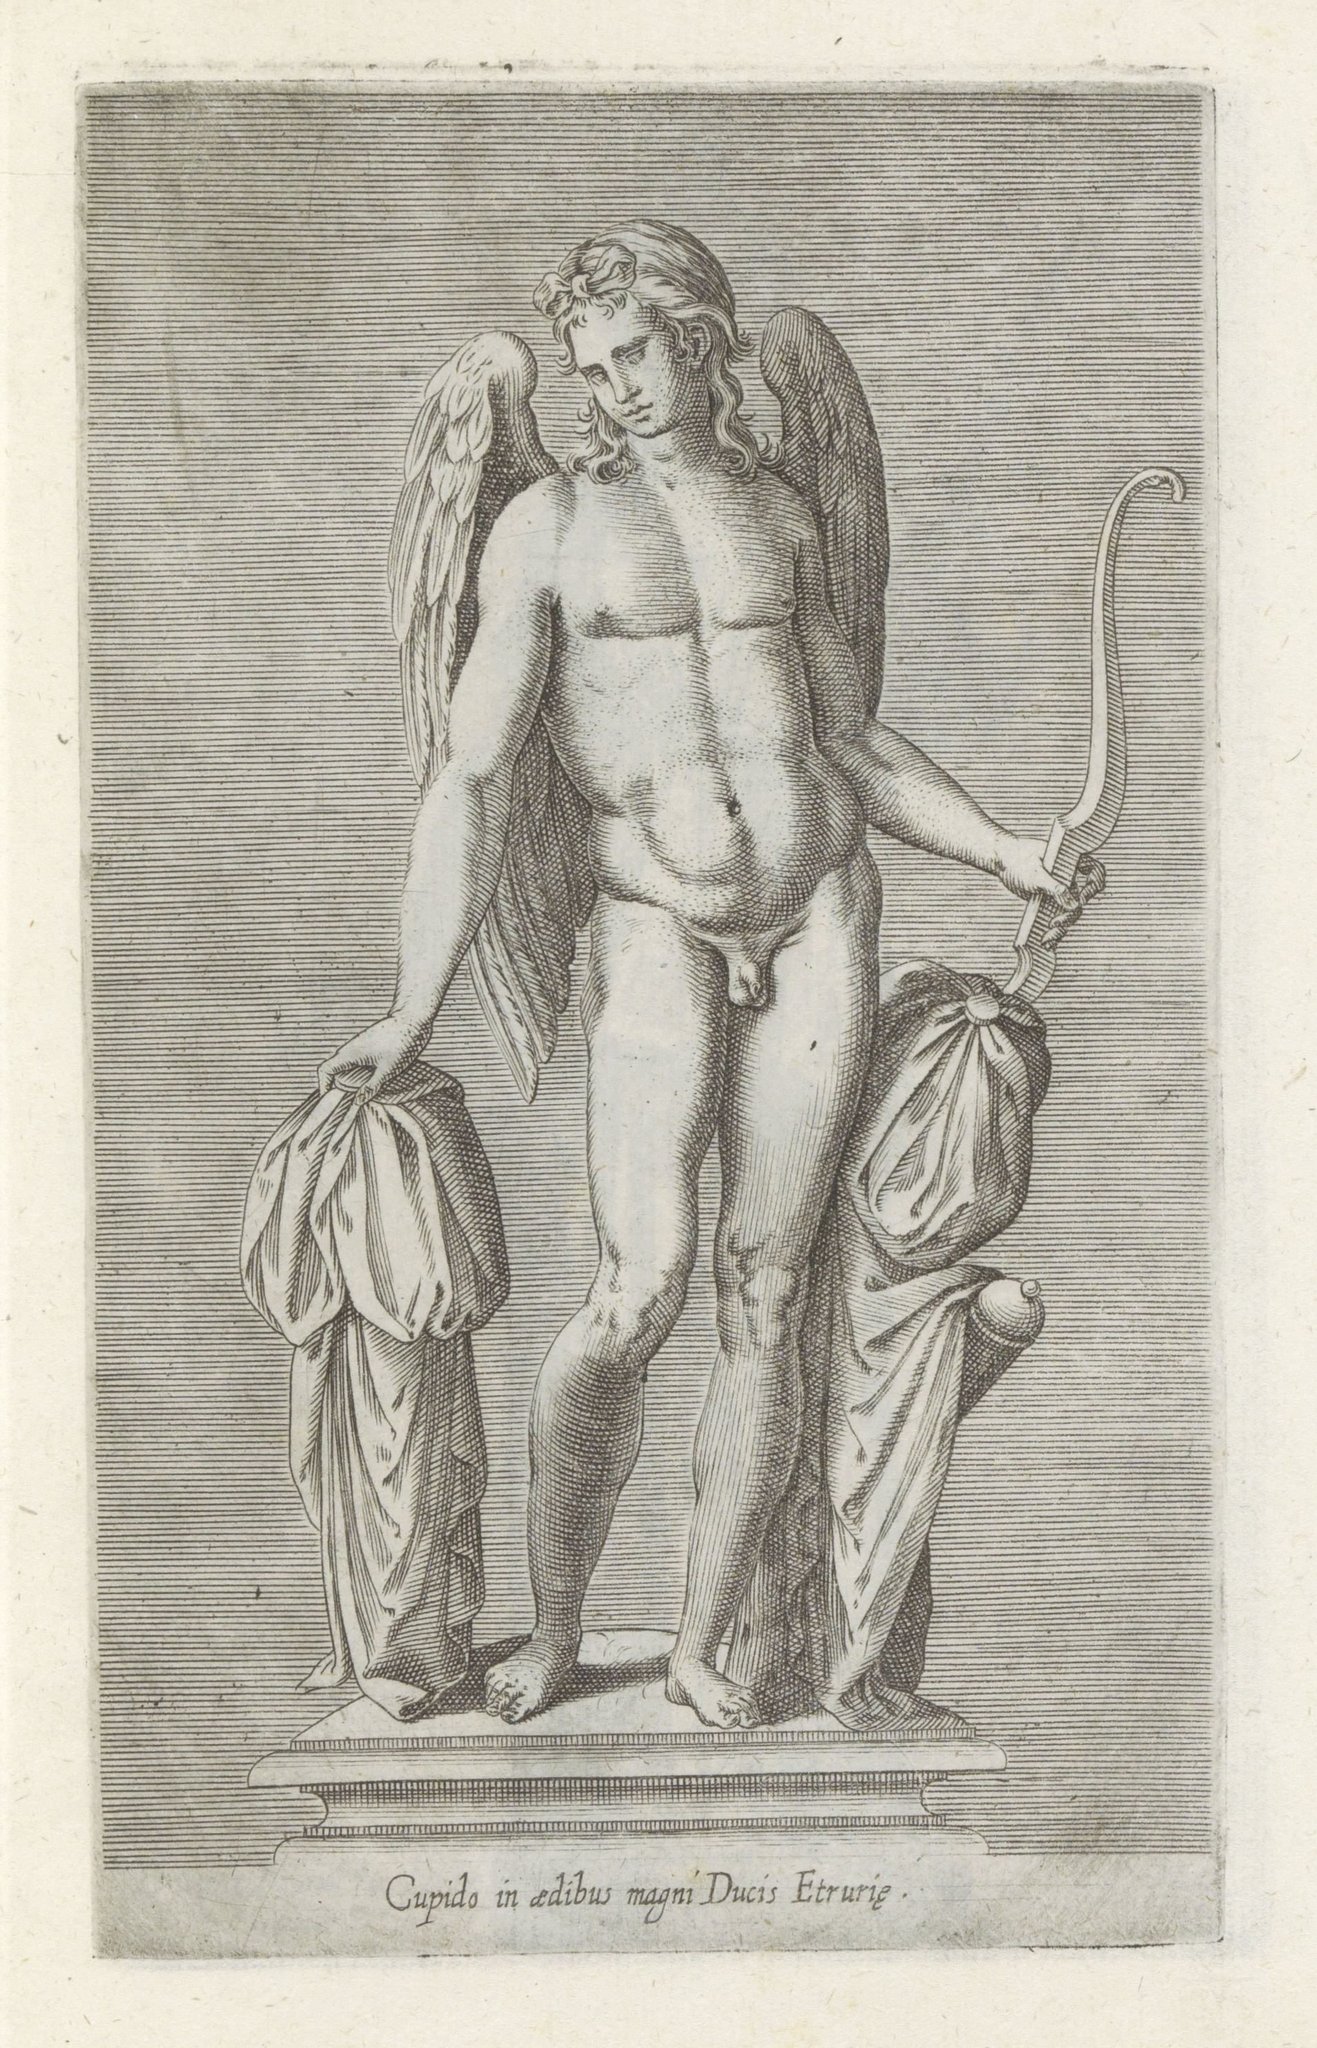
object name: album leaf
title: Sculptuur van Amor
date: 1584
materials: paper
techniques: engraving, intaglio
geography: italy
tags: piece of sculpture, reproduction of a piece of sculpture, (story of) cupid, amor (eros)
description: Deze prent maakt deel uit van een set van 79 prenten (+ titelprent) met voorstellingen van antieke sculpturen in Rome.